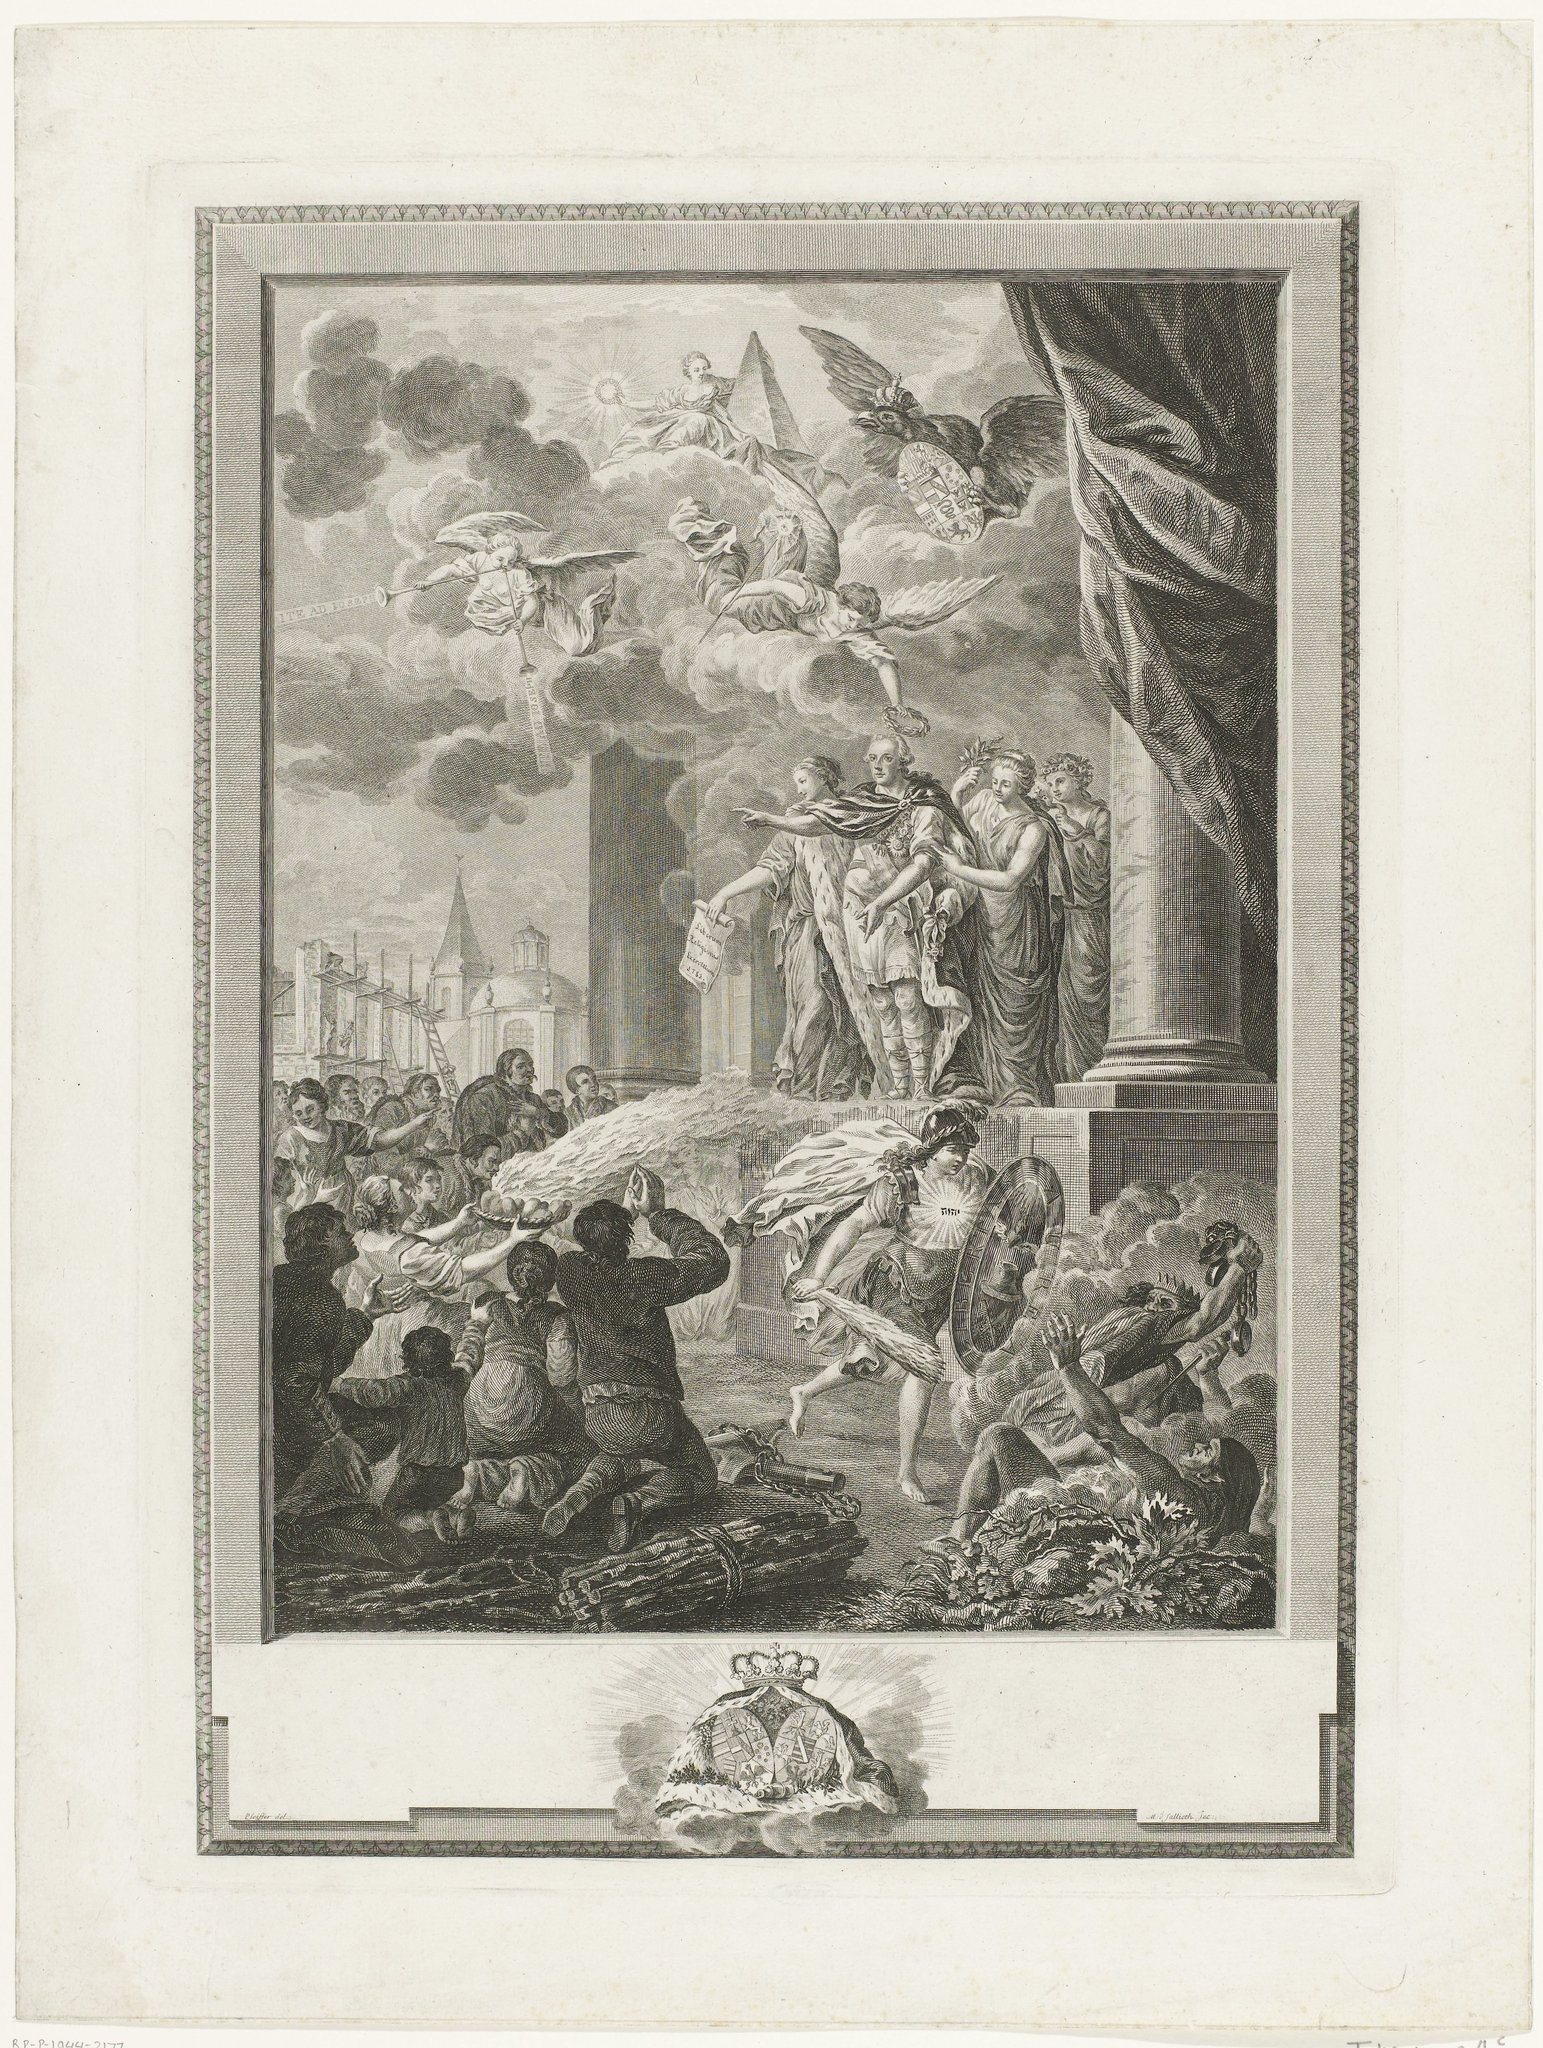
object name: print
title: Clementie van keizer Jozef II aan de protestanten, 1783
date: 1783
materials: paper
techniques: engraving, etching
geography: rotterdam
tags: maria christina van oostenrijk (1742-1798), vienna, jozef ii (duits keizer), prudence, 'prudentia'; 'prudenza' (ripa) ~ one of the four cardinal virtues, tolerance, long-suffering; 'longanimità', 'toleranza' (ripa) (+ abstract concept represented by female figure), indulgence, clemency; 'clemenza', 'clemenza & moderatione', 'indulgenza' (ripa) (+ abstract concept represented by female figure), the christian knight, 'miles christianus', building of church, allegories and personifications ~ protestantism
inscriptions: collector's mark: Lugt 2228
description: Allegorie op het edict van Joseph II over de godsdienstvrijheid voor protestanten, maart 1783. De keizer staat op het bordes van een tempel en wordt gekroond door de geest der Wijsheid. Naast de keizer de personificaties van Verdraagzaamheid, Goedertierenheid en Voorzichtigheid. Voor de keizer knielen (Hongaarse) protestantse onderdanen die hem in dankbaarheid hun harten aanbieden. Rechts worden de Dwingelandij en de Onwetendheid verjaagd door de Vrijheid van Godsdienst in harnas met vlammend zwaard en schild waarop 'Aurea libertas'. Op de achtergrond een protestantse kerk in aanbouw. Onderaan de wapens van de keizer en zijn zuster Maria Christina van Oostenrijk.